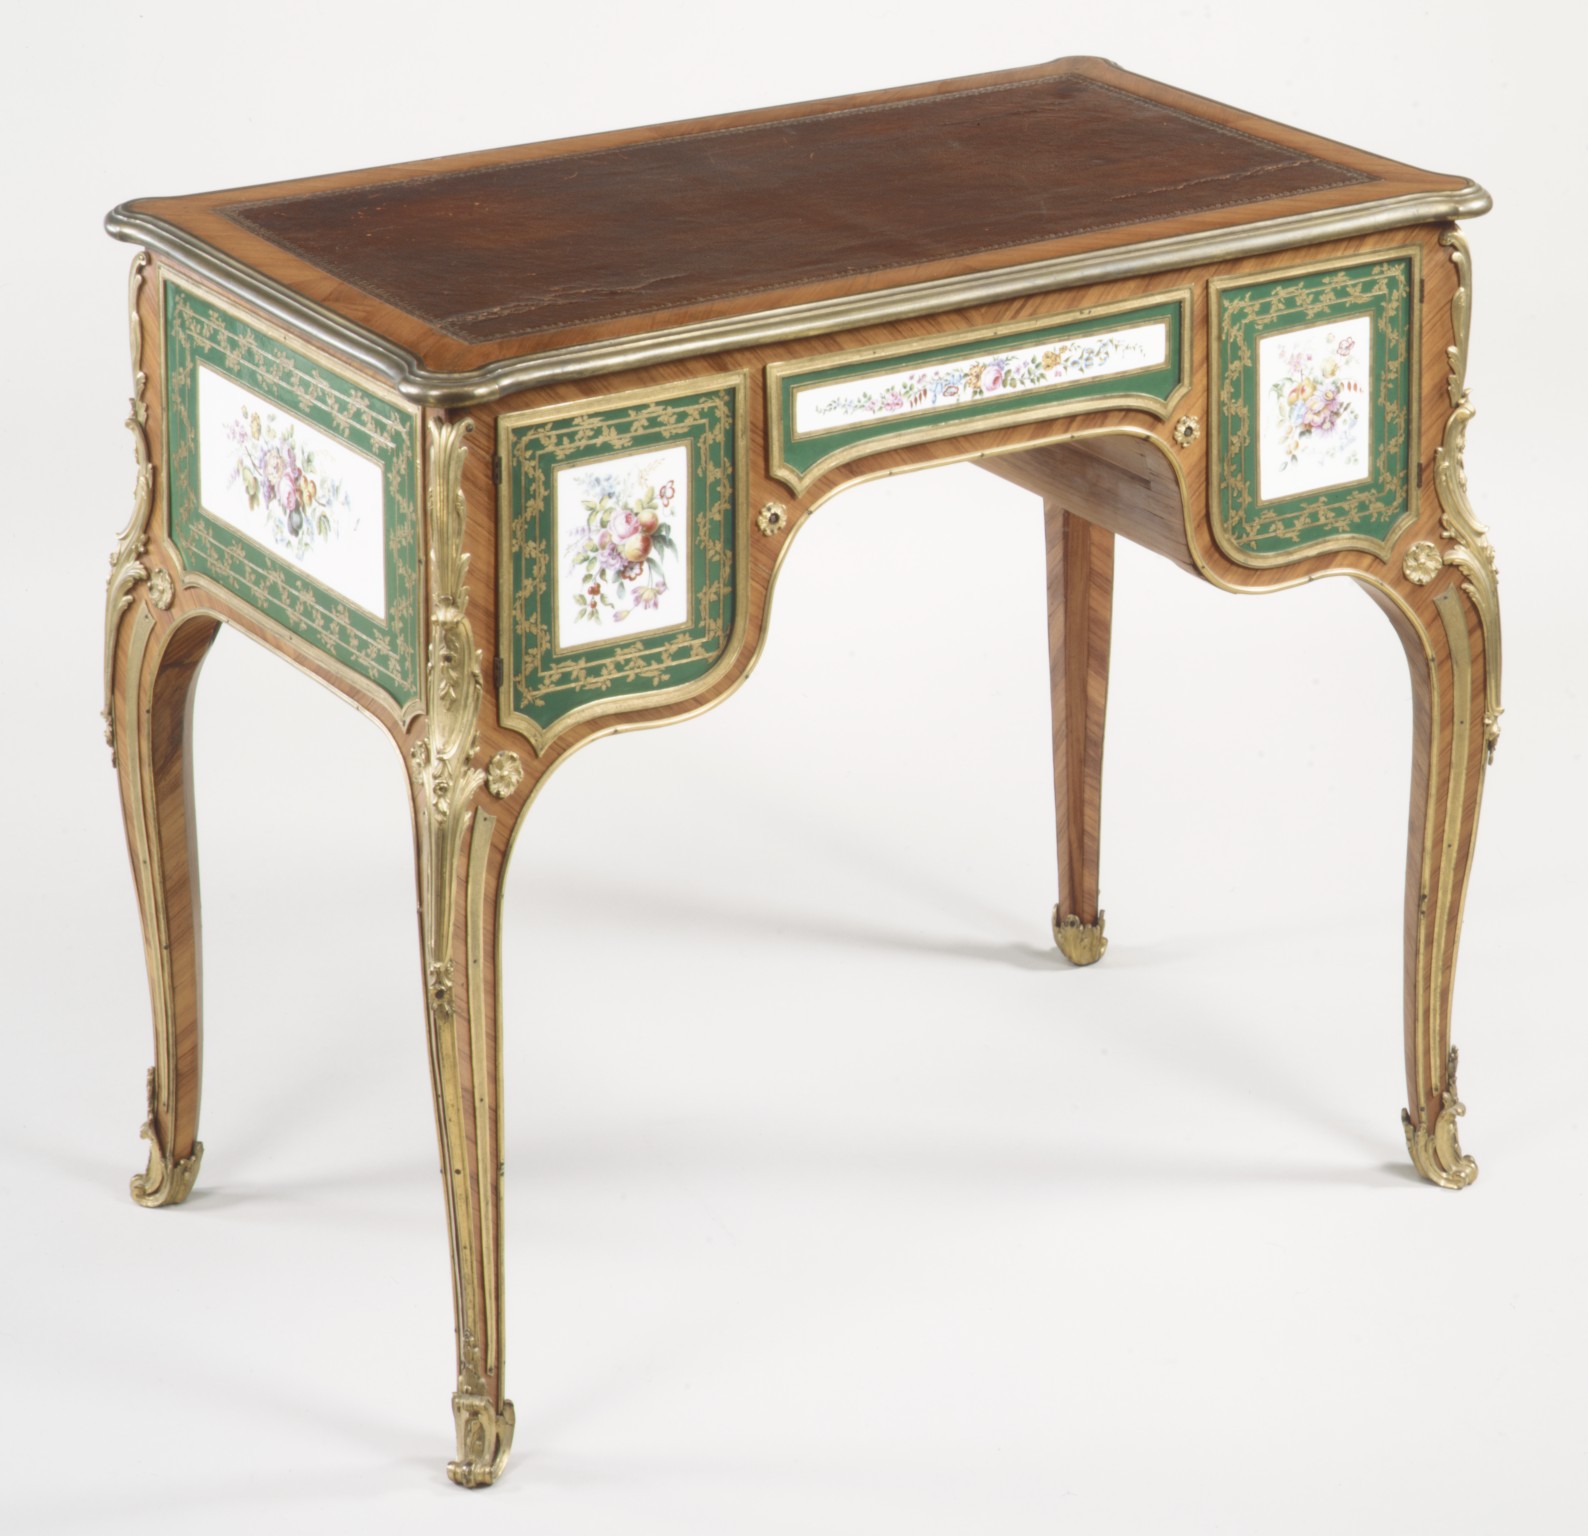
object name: desk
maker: joseph baumhauer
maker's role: maker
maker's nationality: french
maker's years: 1749-1772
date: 1770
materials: gilt bronze, leather, wood, silk, soft paste porcelain